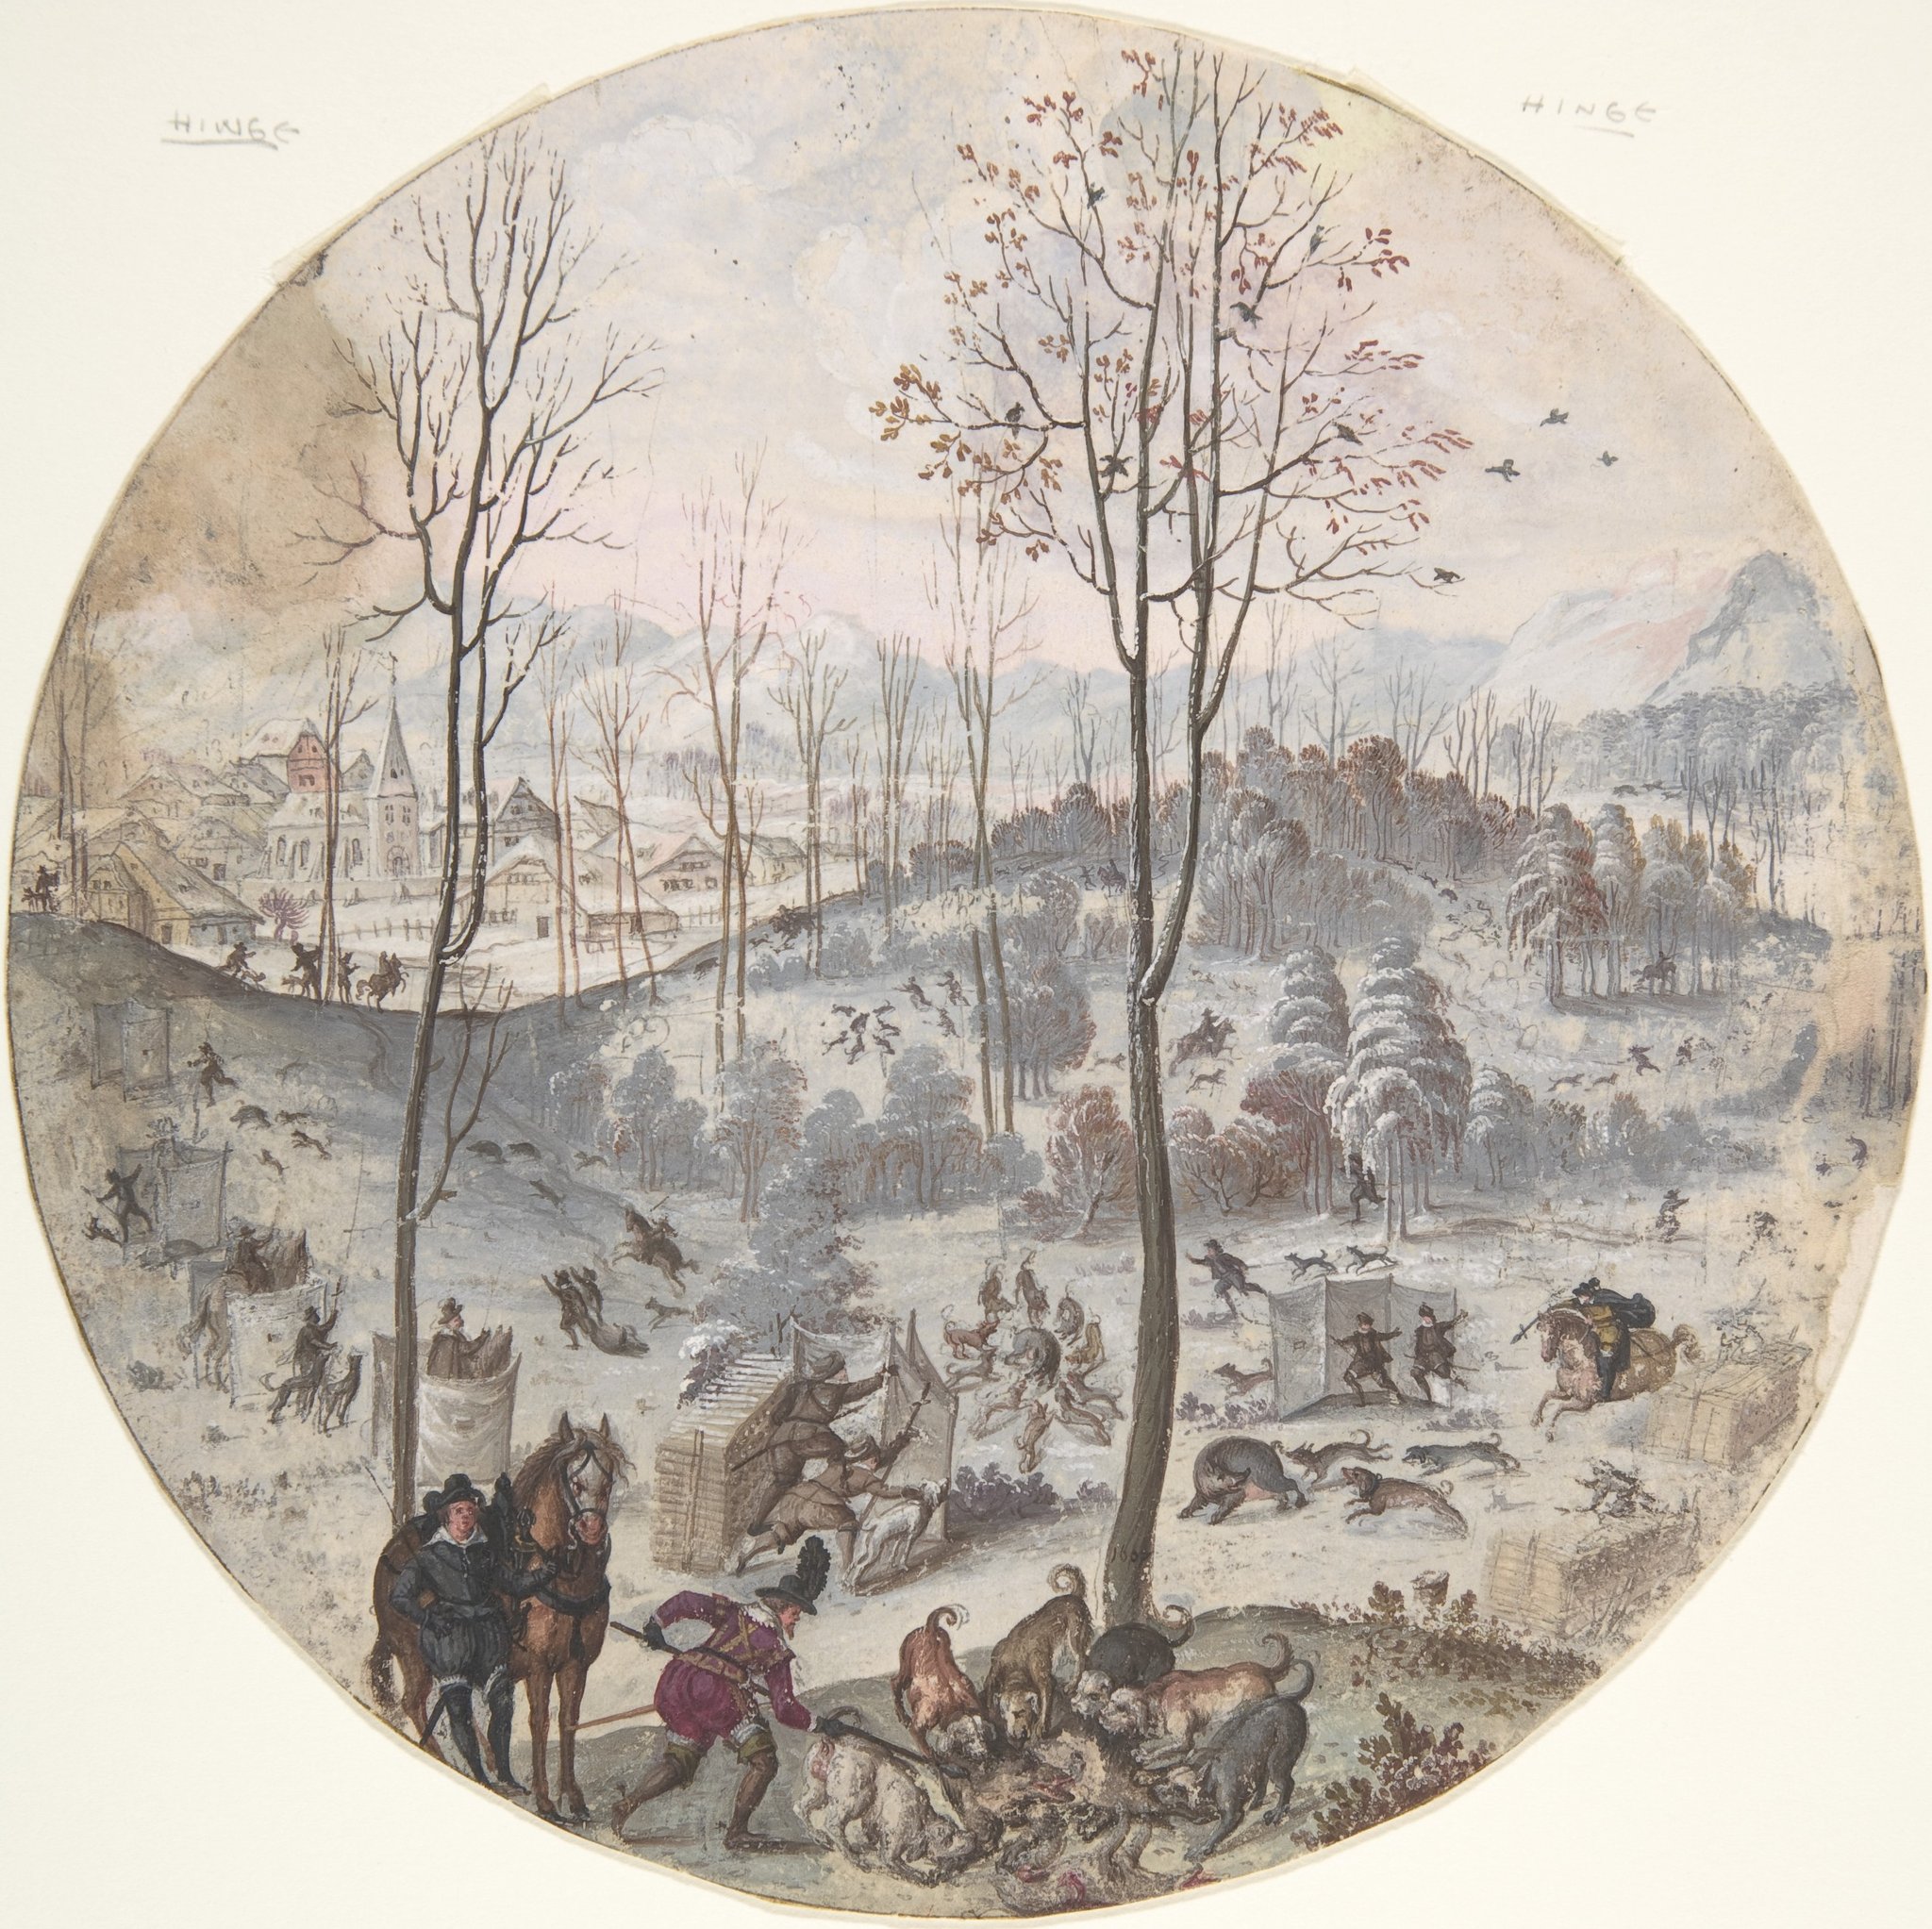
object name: drawing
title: A Boar Hunt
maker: anonymous, flemish, 17th century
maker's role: artist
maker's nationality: flemish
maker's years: 1600-1700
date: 1601-1700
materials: paint, watercolor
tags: human figures,hunting,boars,horses,trees